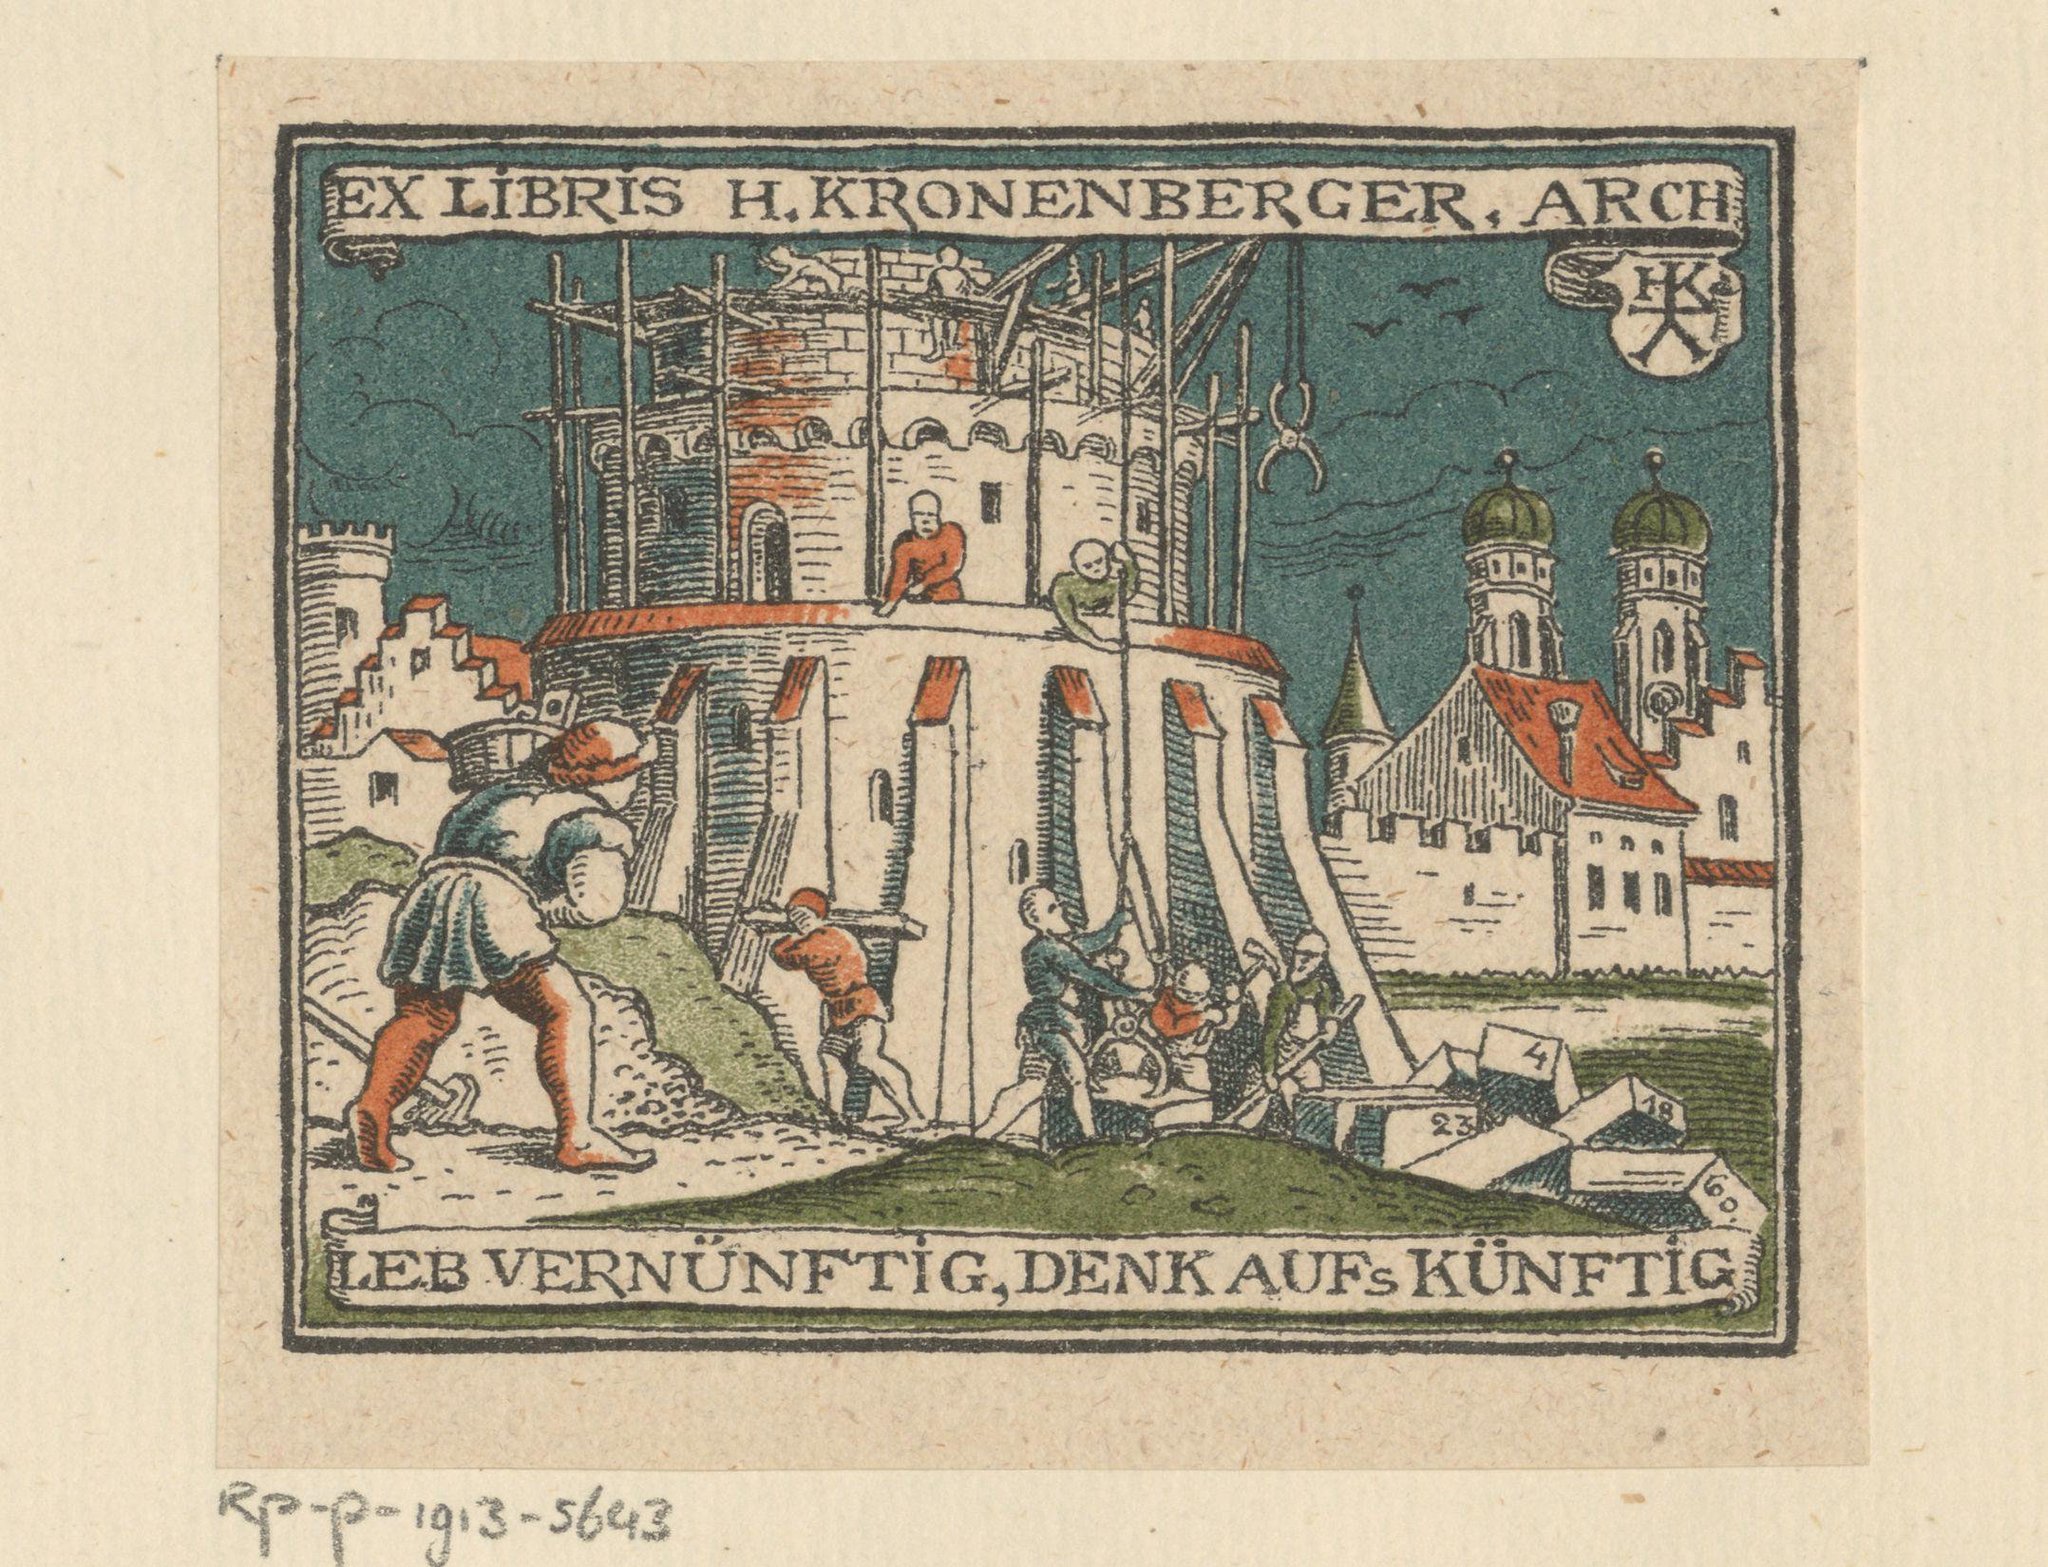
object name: bookplate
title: Leb Vernünftig, denk aufs Künftig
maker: Anonymous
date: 1860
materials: paper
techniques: printing block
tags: building-site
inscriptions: collector's mark: Lugt 2233, collector's mark: Lugt 2760